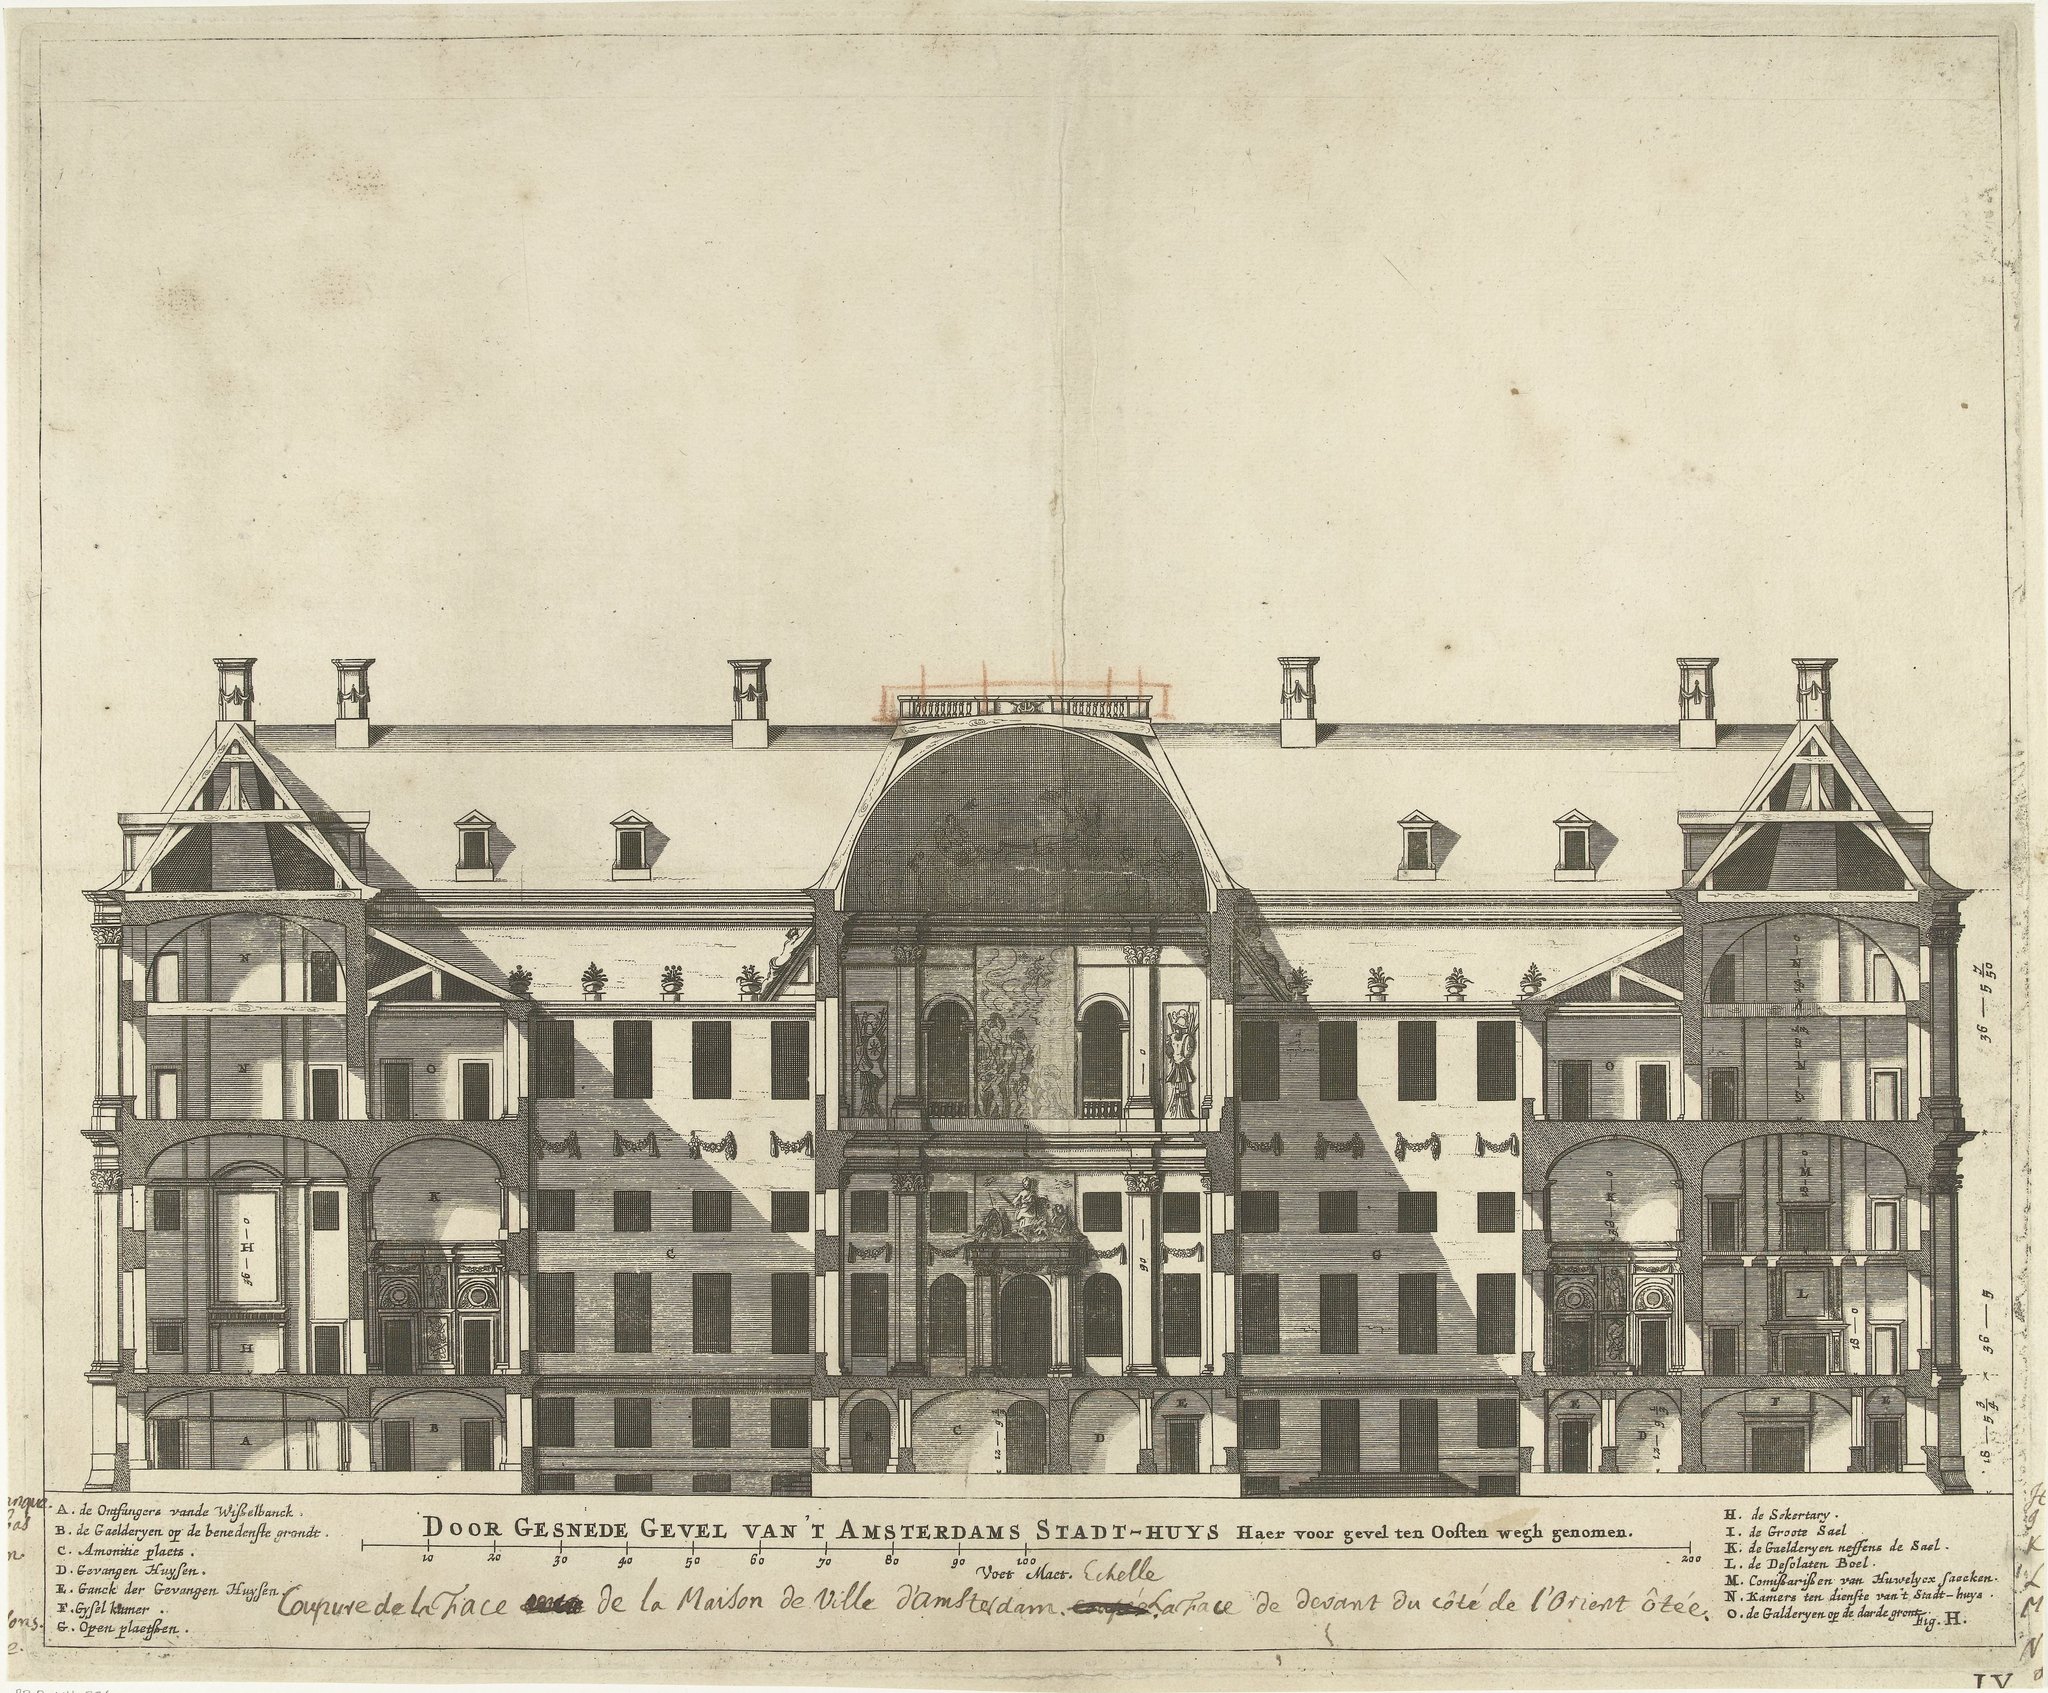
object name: book illustration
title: Doorsnede van het Stadhuis op de Dam, door de lengte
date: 1661-1706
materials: ink, paper, pencil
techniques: engraving, etching, pen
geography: amsterdam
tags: townhall, exterior ~ representation of a building, interior ~ representation of a building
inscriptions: collector's mark: Lugt 2228, inscription: ‘Coupure de la Face de la Maison de Ville d'Amsterdam. La Face de devant du côté de l'Orient ôtée’, inscription: ‘Echelle’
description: Lengtedoorsnede van het Stadhuis op de Dam te Amsterdam. Geeft zicht op een deel van de binnenkant en de gevel van de binnenplaats van het achterste (westelijke) deel van het gebouw, gezien vanuit het oosten. Linksonder de legenda A-G. Onder in het midden de titel en een schaalstok: 200 Voet Maet. Rechtsonder de legenda H-O. Rechtsonder in de hoek gemerkt: Fig. H. De titel is vertaald in handgeschreven Franse tekst.